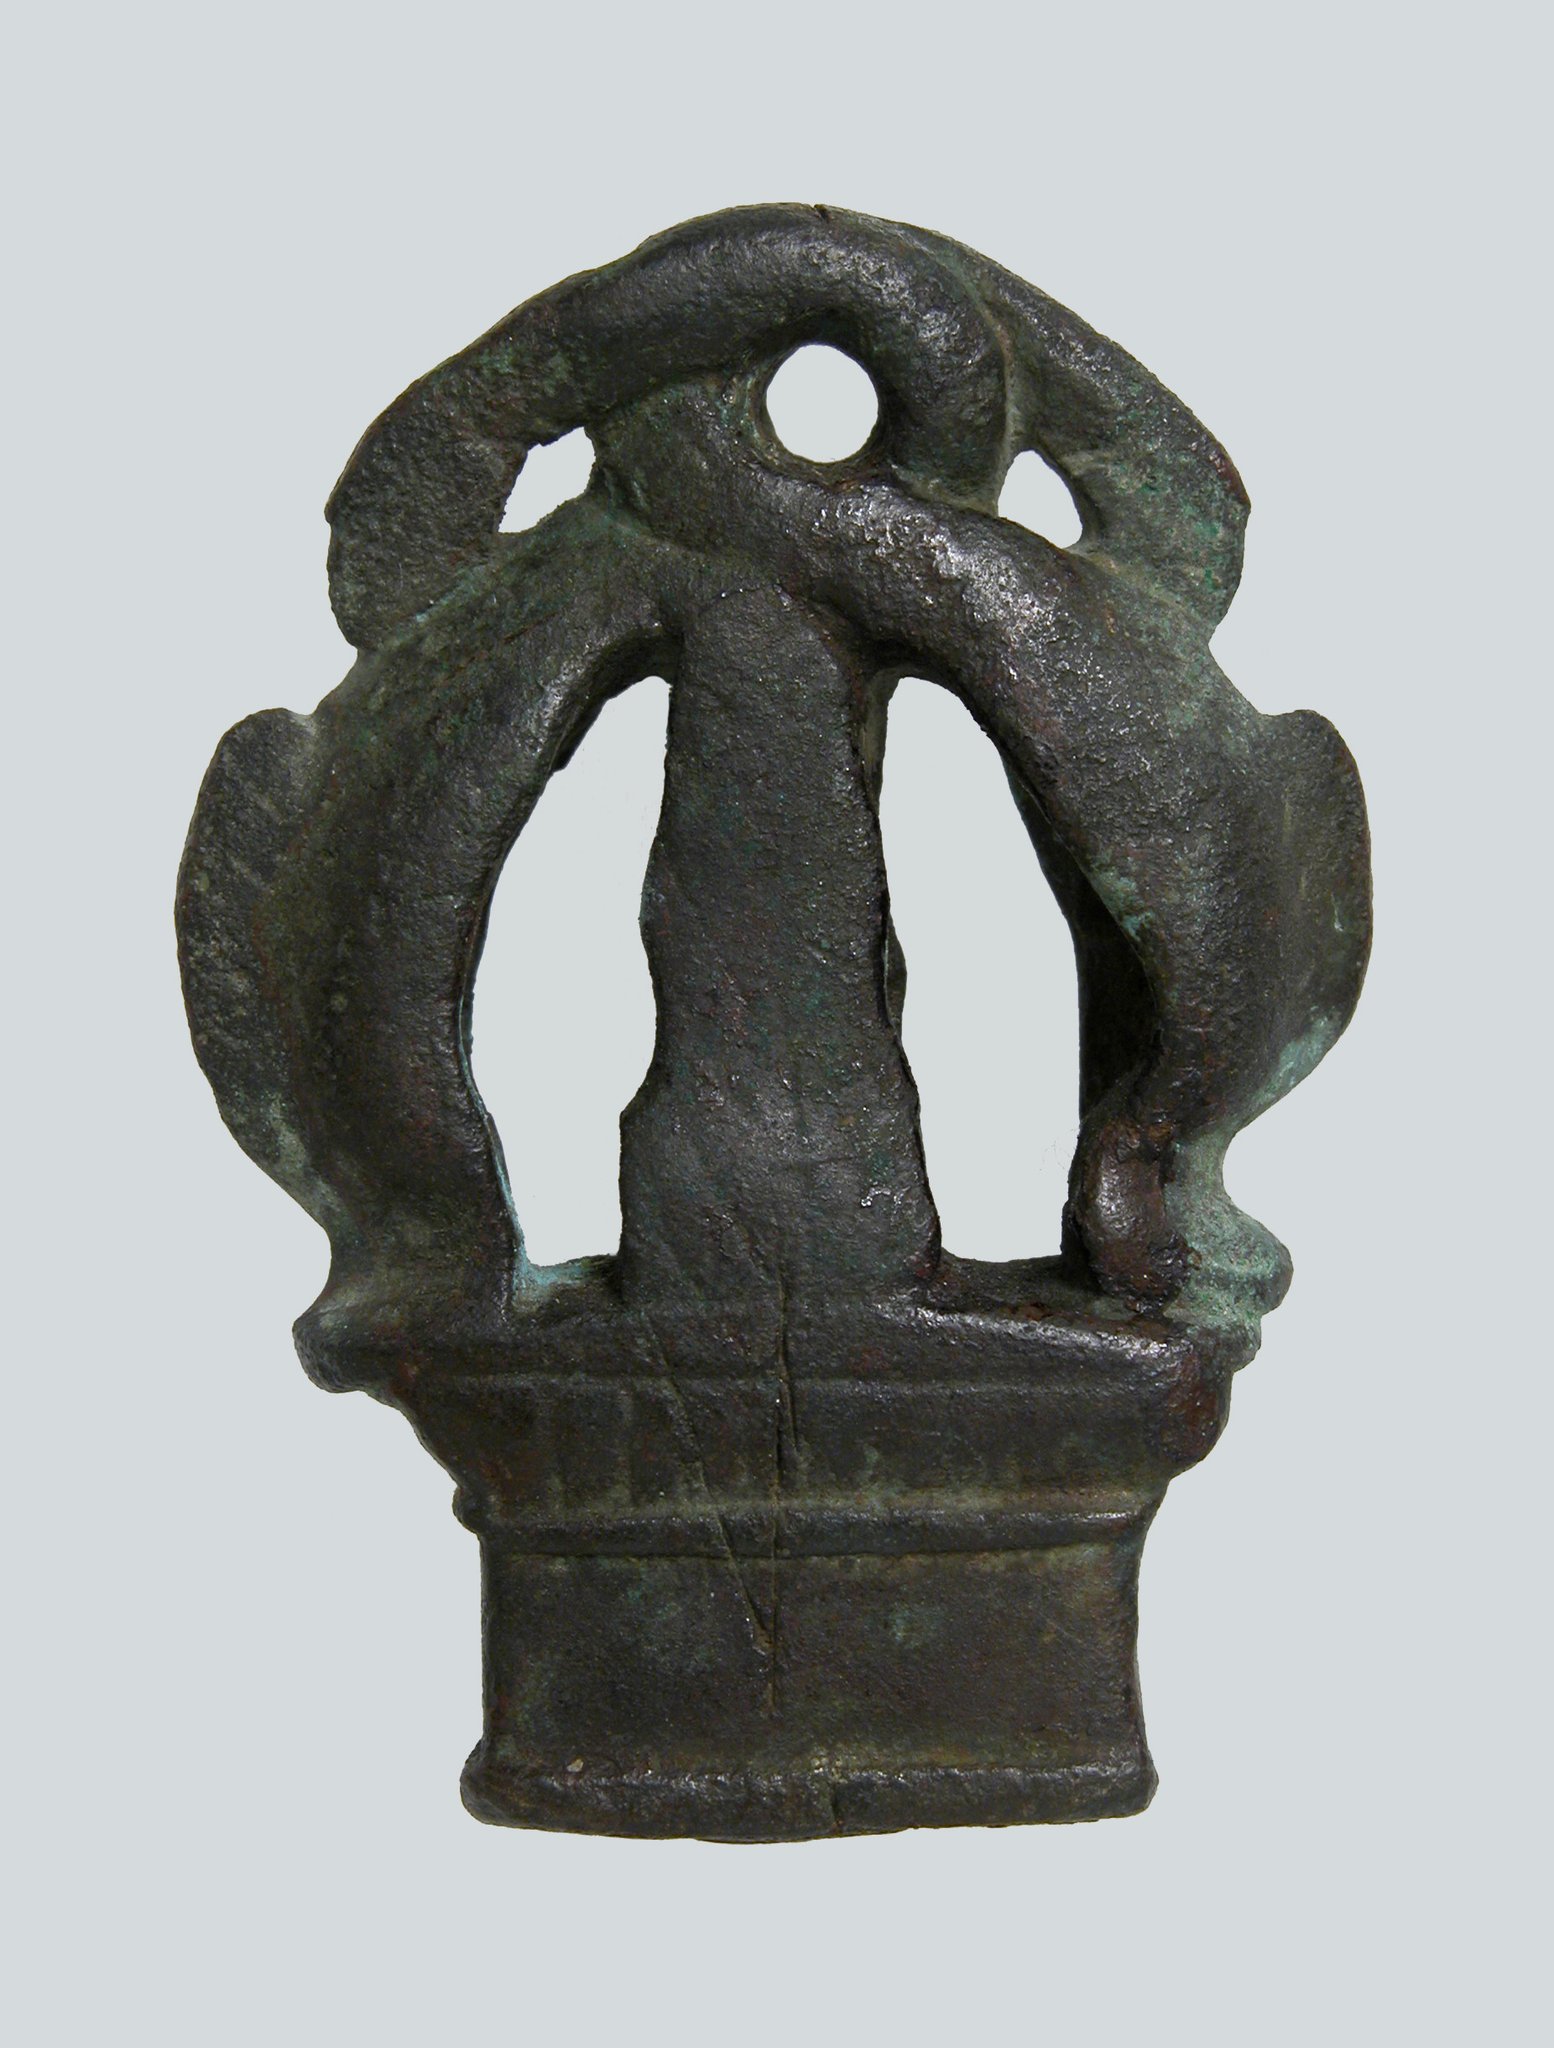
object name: sword or dagger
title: Head of Sword or Dagger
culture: roman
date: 101-300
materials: copper alloy